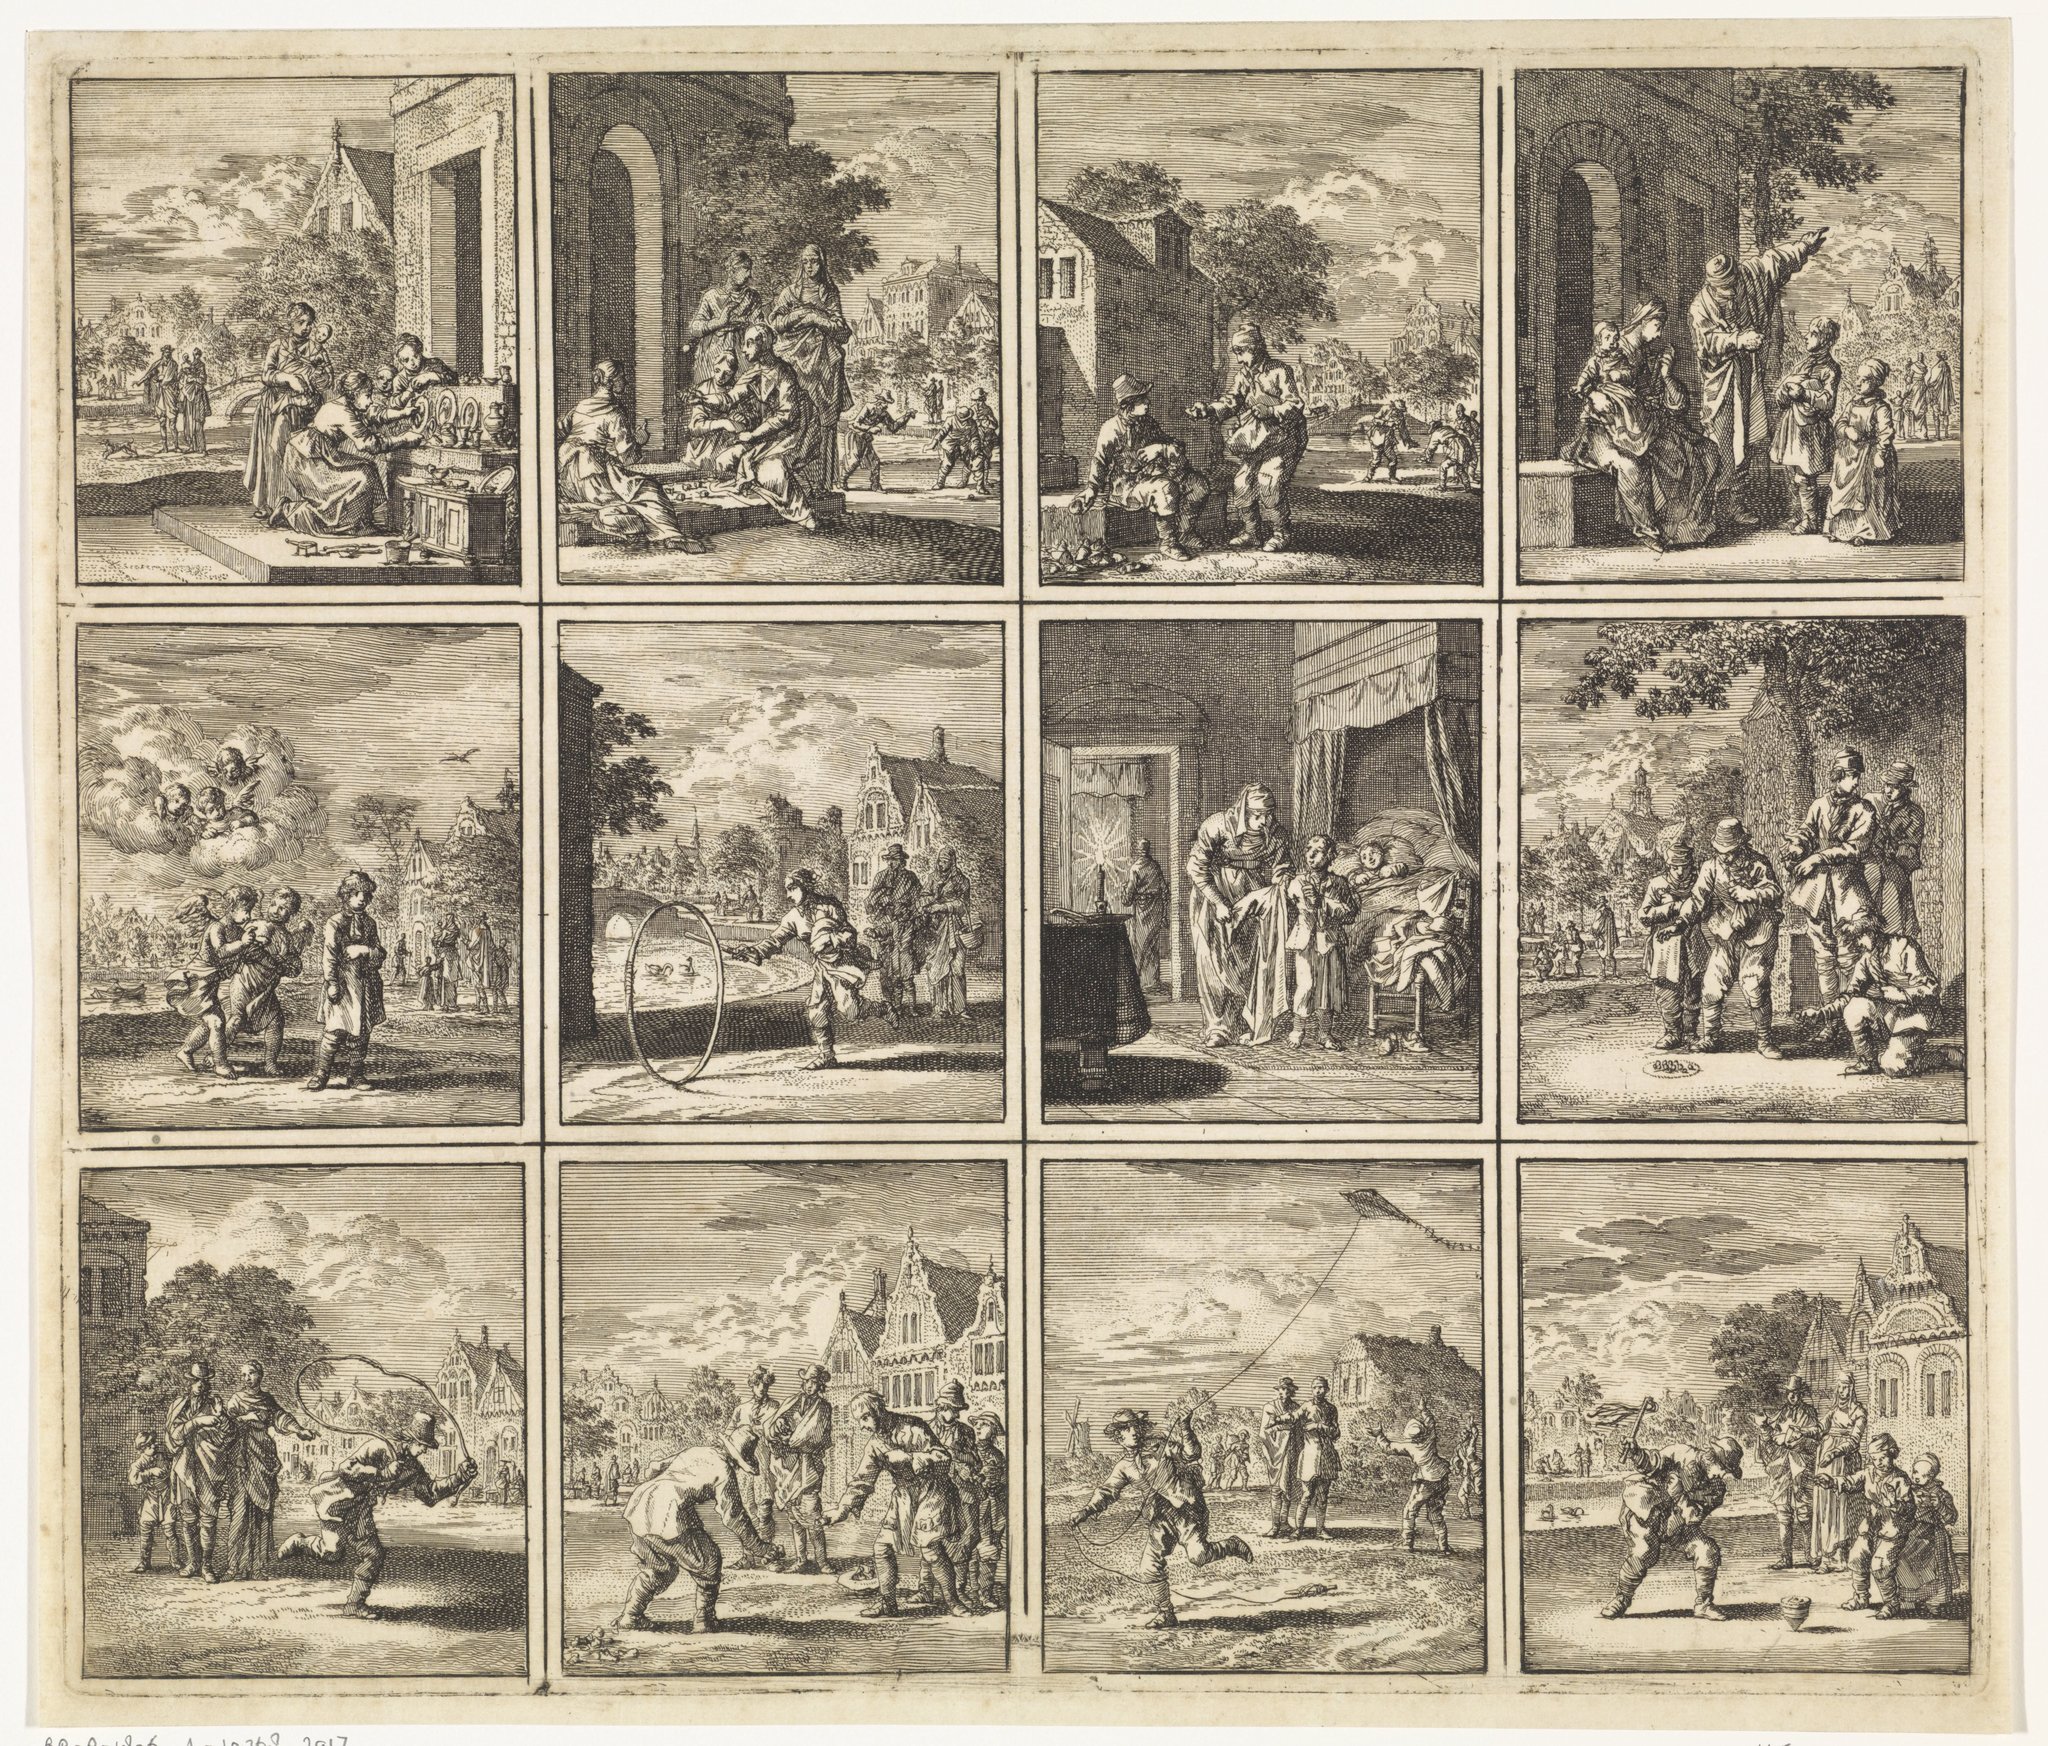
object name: book illustration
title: Twaalf afbeeldingen uit 'Des menschen begin, midden en einde'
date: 1712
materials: paper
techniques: etching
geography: amsterdam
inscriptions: collector's mark: Lugt 2228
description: Prenten gebruikt als illustratie in: Luyken, Jan. Des menschen begin, midden en einde. Amsterdam: Wed. Pieter Arentsz II en Cornelis van der Sys, 1712.